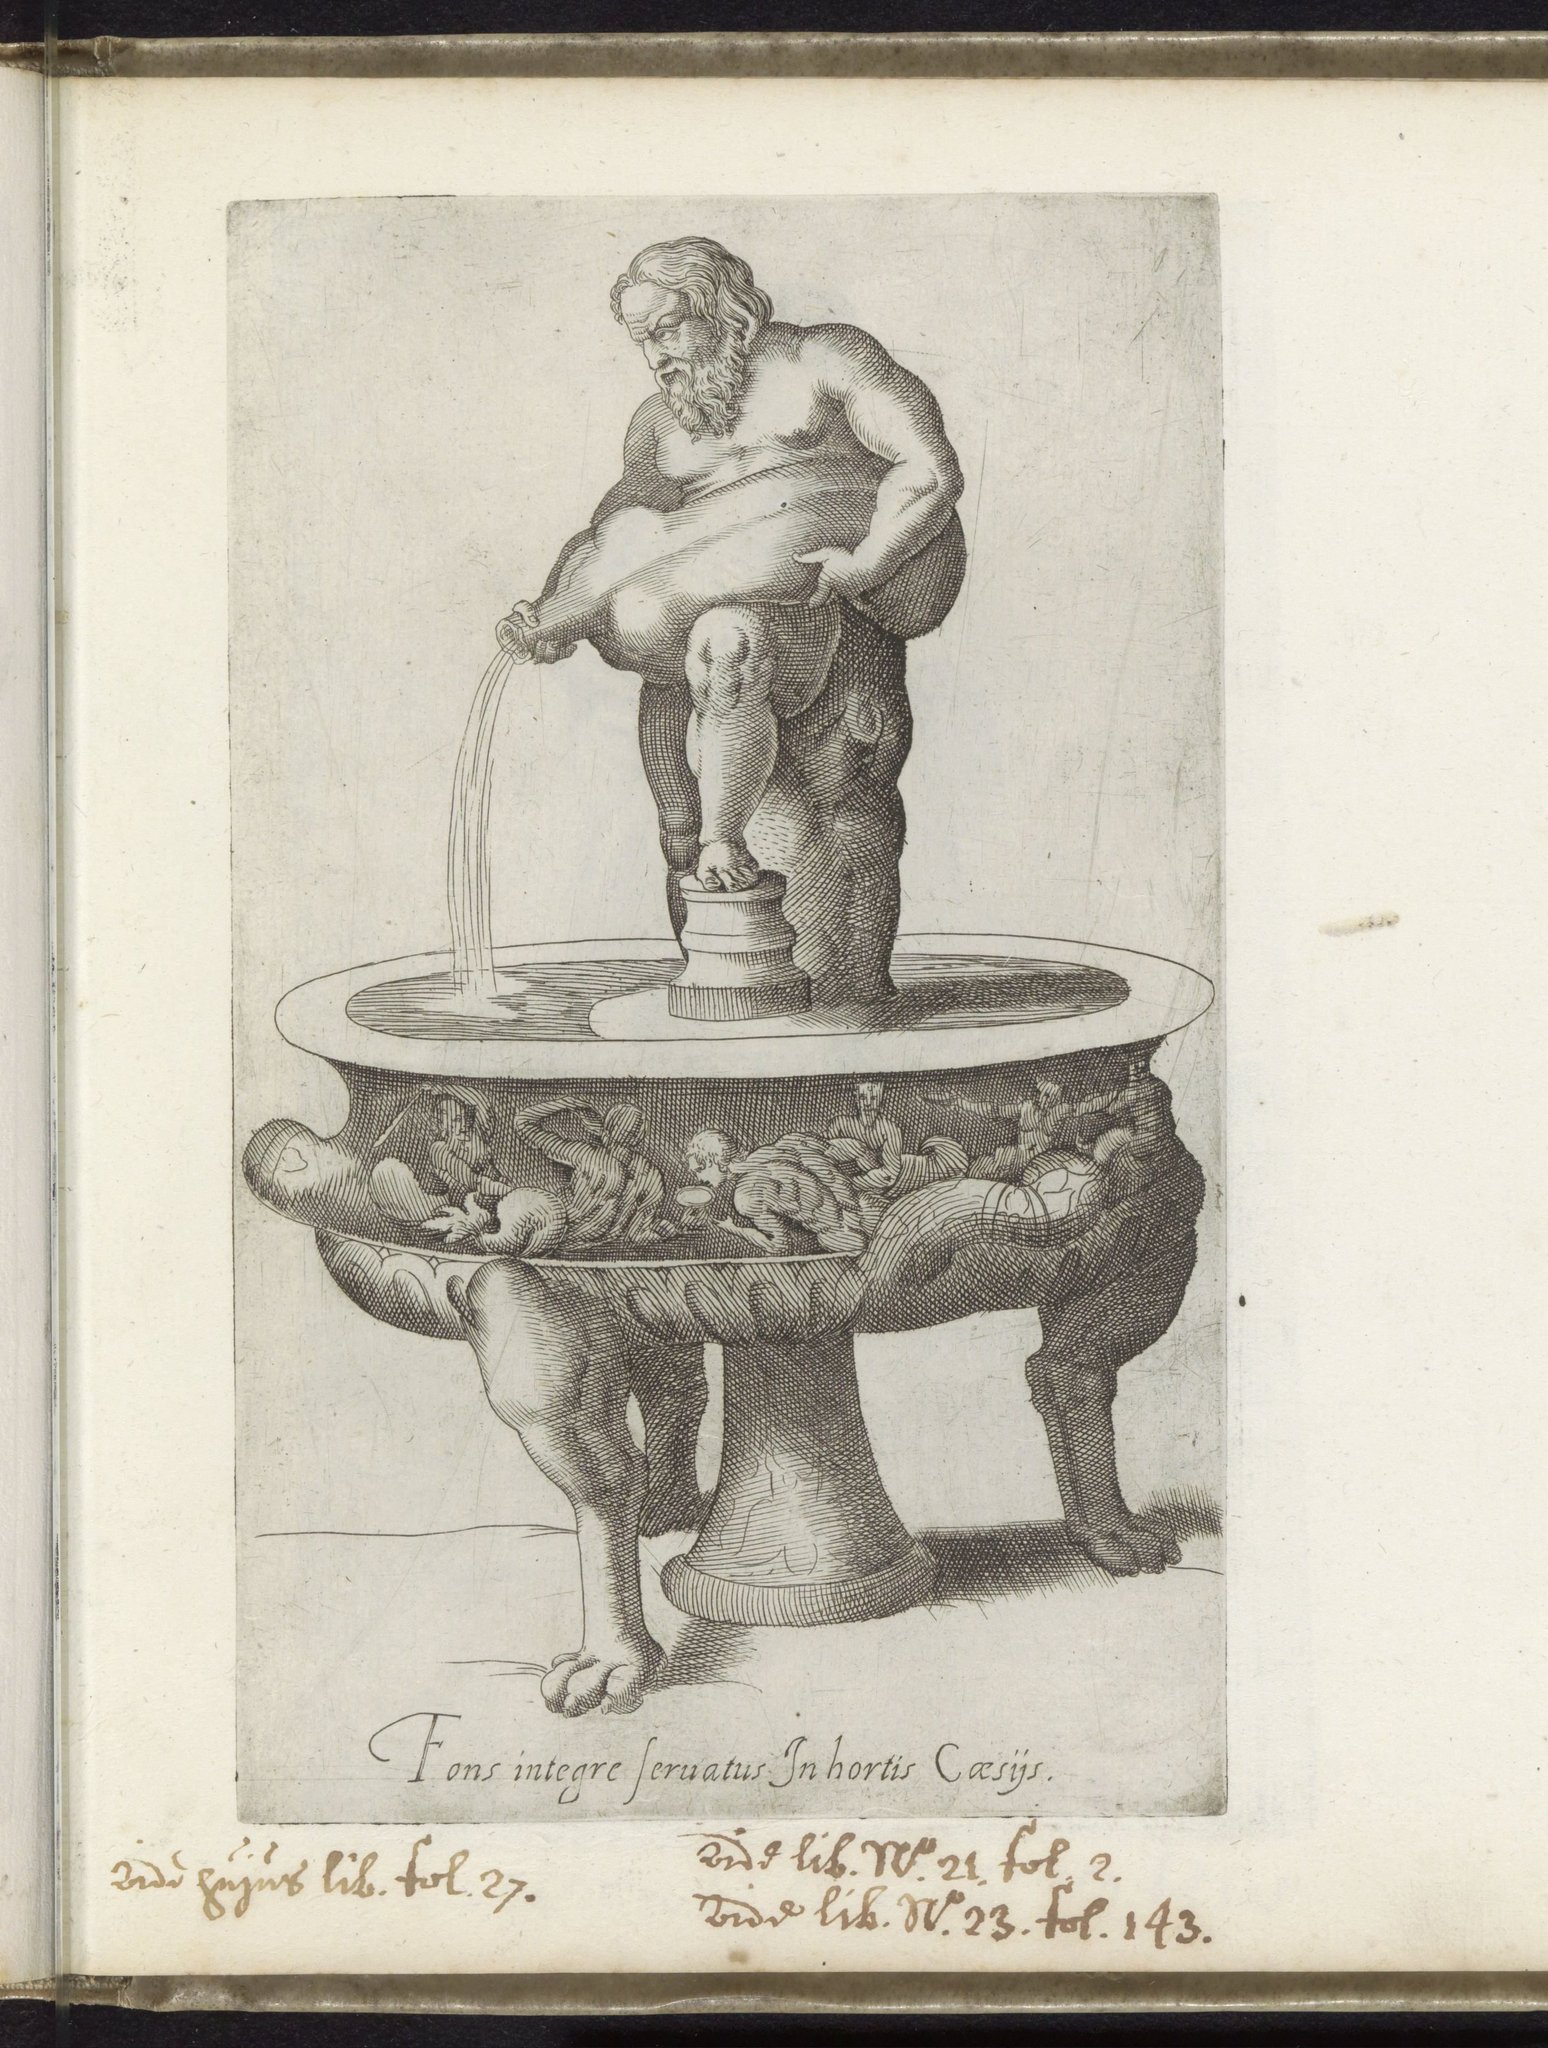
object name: album leaf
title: Fontein bestaande uit de Torloni vaas en een sculptuur van Silenus met een wijnzak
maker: Anonymous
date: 1600-1699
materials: paper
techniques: engraving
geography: italy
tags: vase ~ ornament, (story of) silenus, piece of sculpture, reproduction of a piece of sculpture, ornamental fountain, garden vase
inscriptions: inscription: ‘Ende [...] lib. No. 27./ Ende lib. No. 21. fol. 2./ Ende lib. No. 23. fol. 143.’, number: ‘85’, inscription: ‘Ende lib. no. 2. fol. 13.’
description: Deze prent maakt deel uit van een reeks van ten minste 50 prenten van sculpturen uit de oudheid.